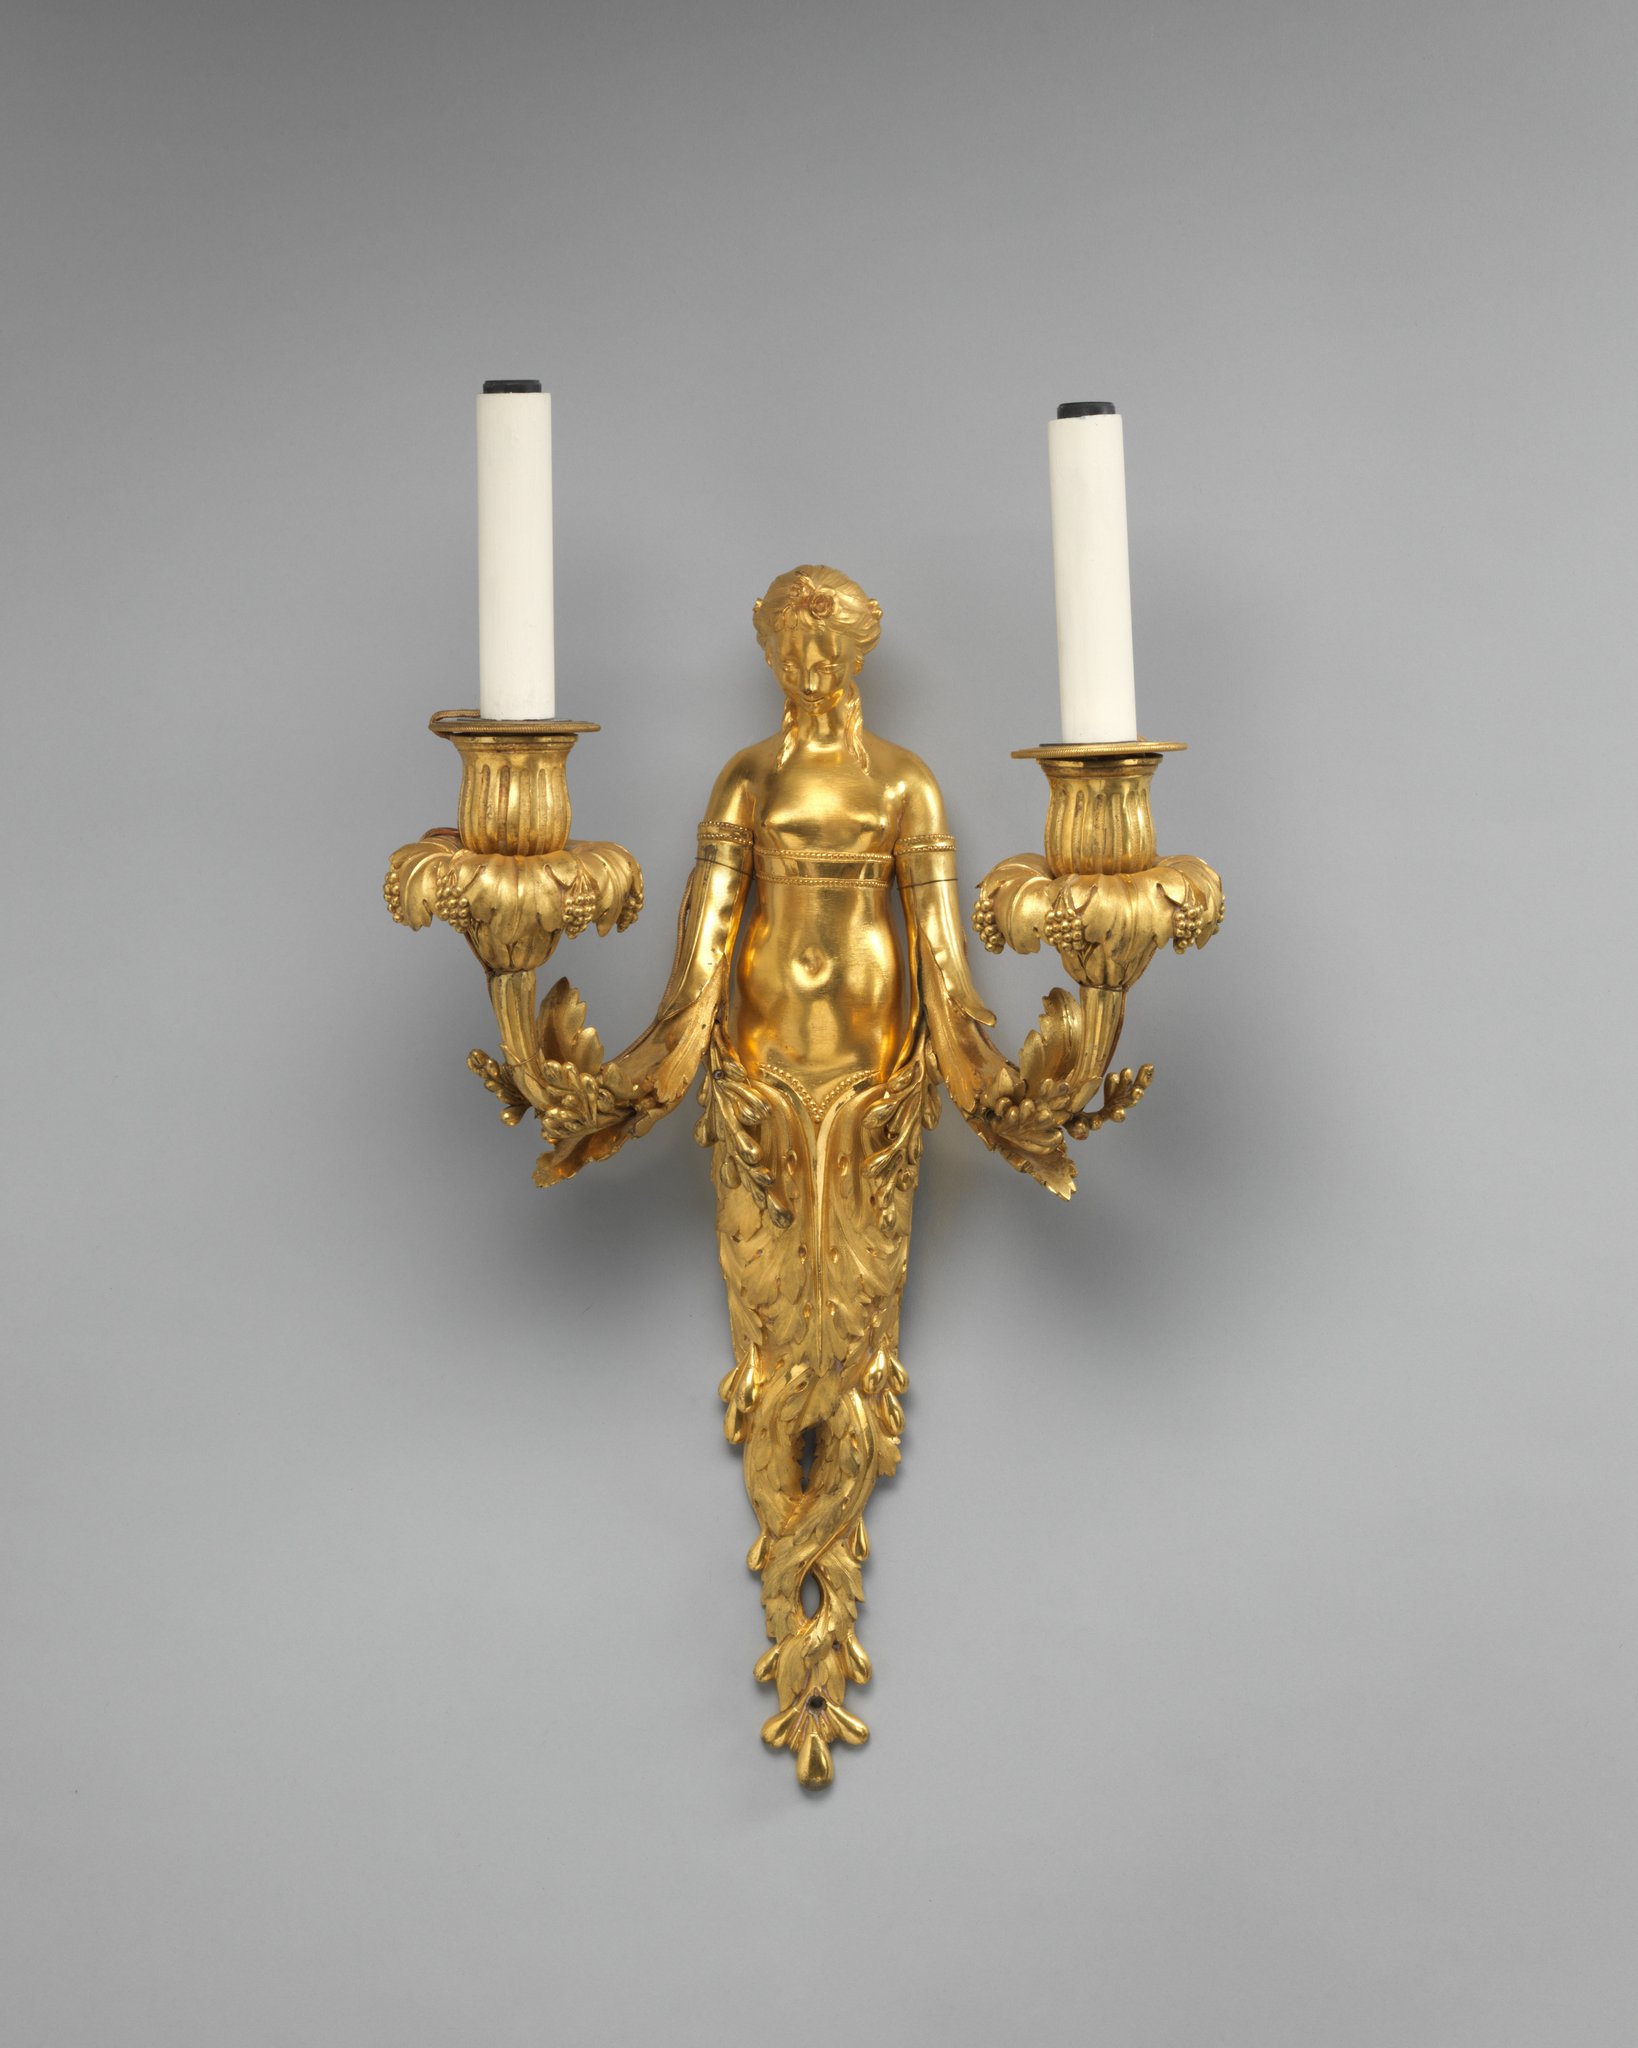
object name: wall light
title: Wall light (bras de lumière) (one of a pair)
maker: robert joseph auguste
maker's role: maker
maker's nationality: french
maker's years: 1723-1805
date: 1775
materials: bronze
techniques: gilding